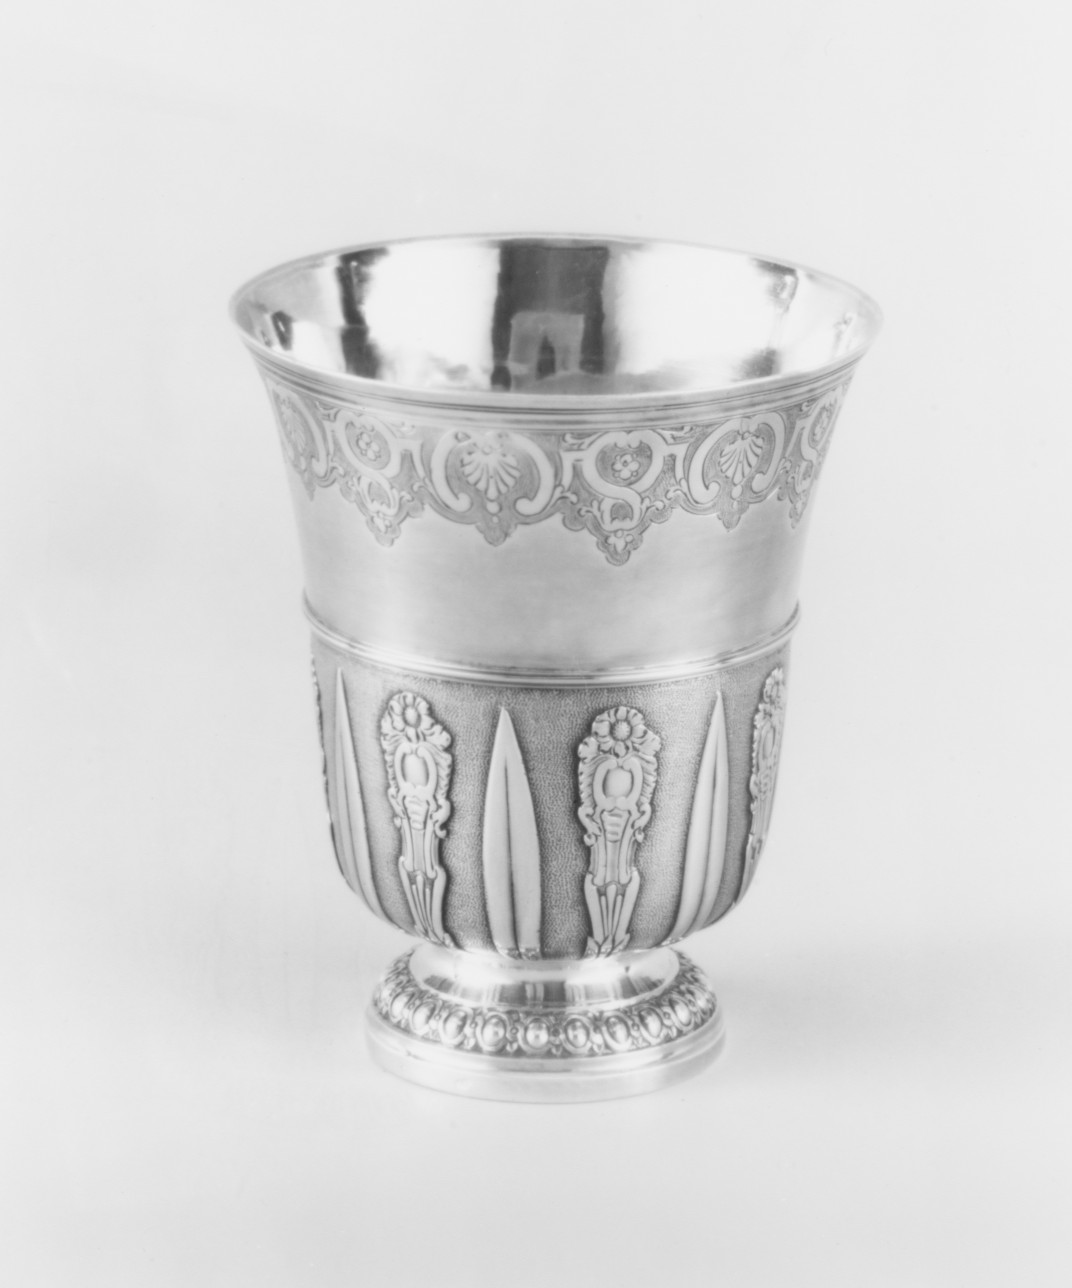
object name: beaker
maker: antoine plot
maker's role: maker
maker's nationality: french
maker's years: 1701-1772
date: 1752-1753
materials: silver